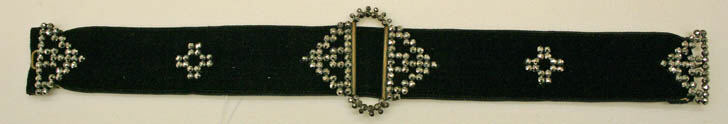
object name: necklace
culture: american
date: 1894